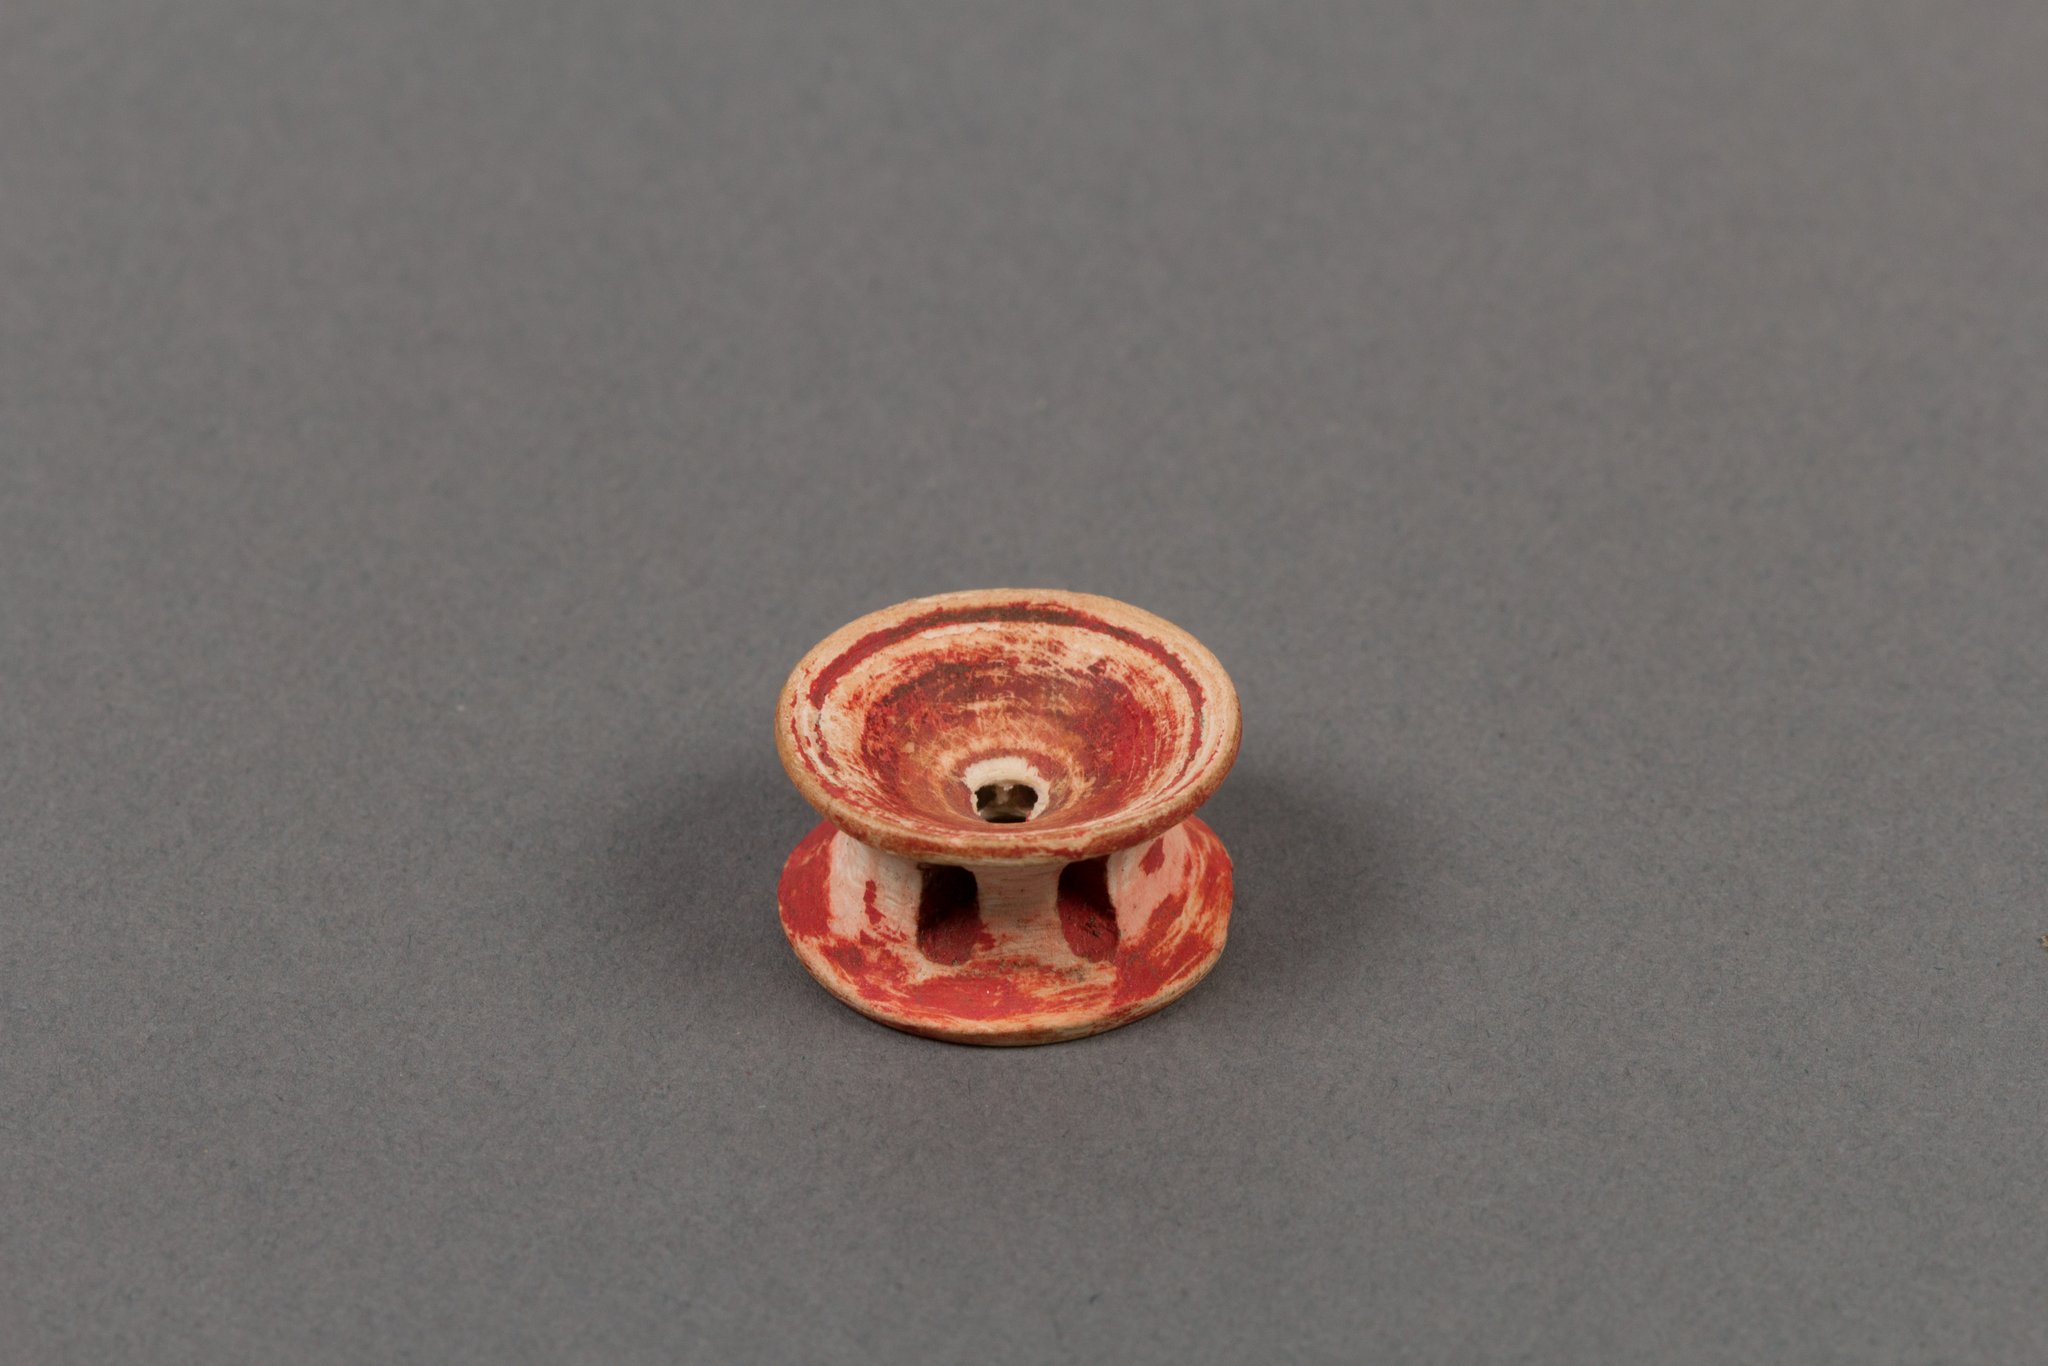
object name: ornament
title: One of a Group of Bone Ornaments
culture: japanese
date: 1000-300 BCE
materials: bone